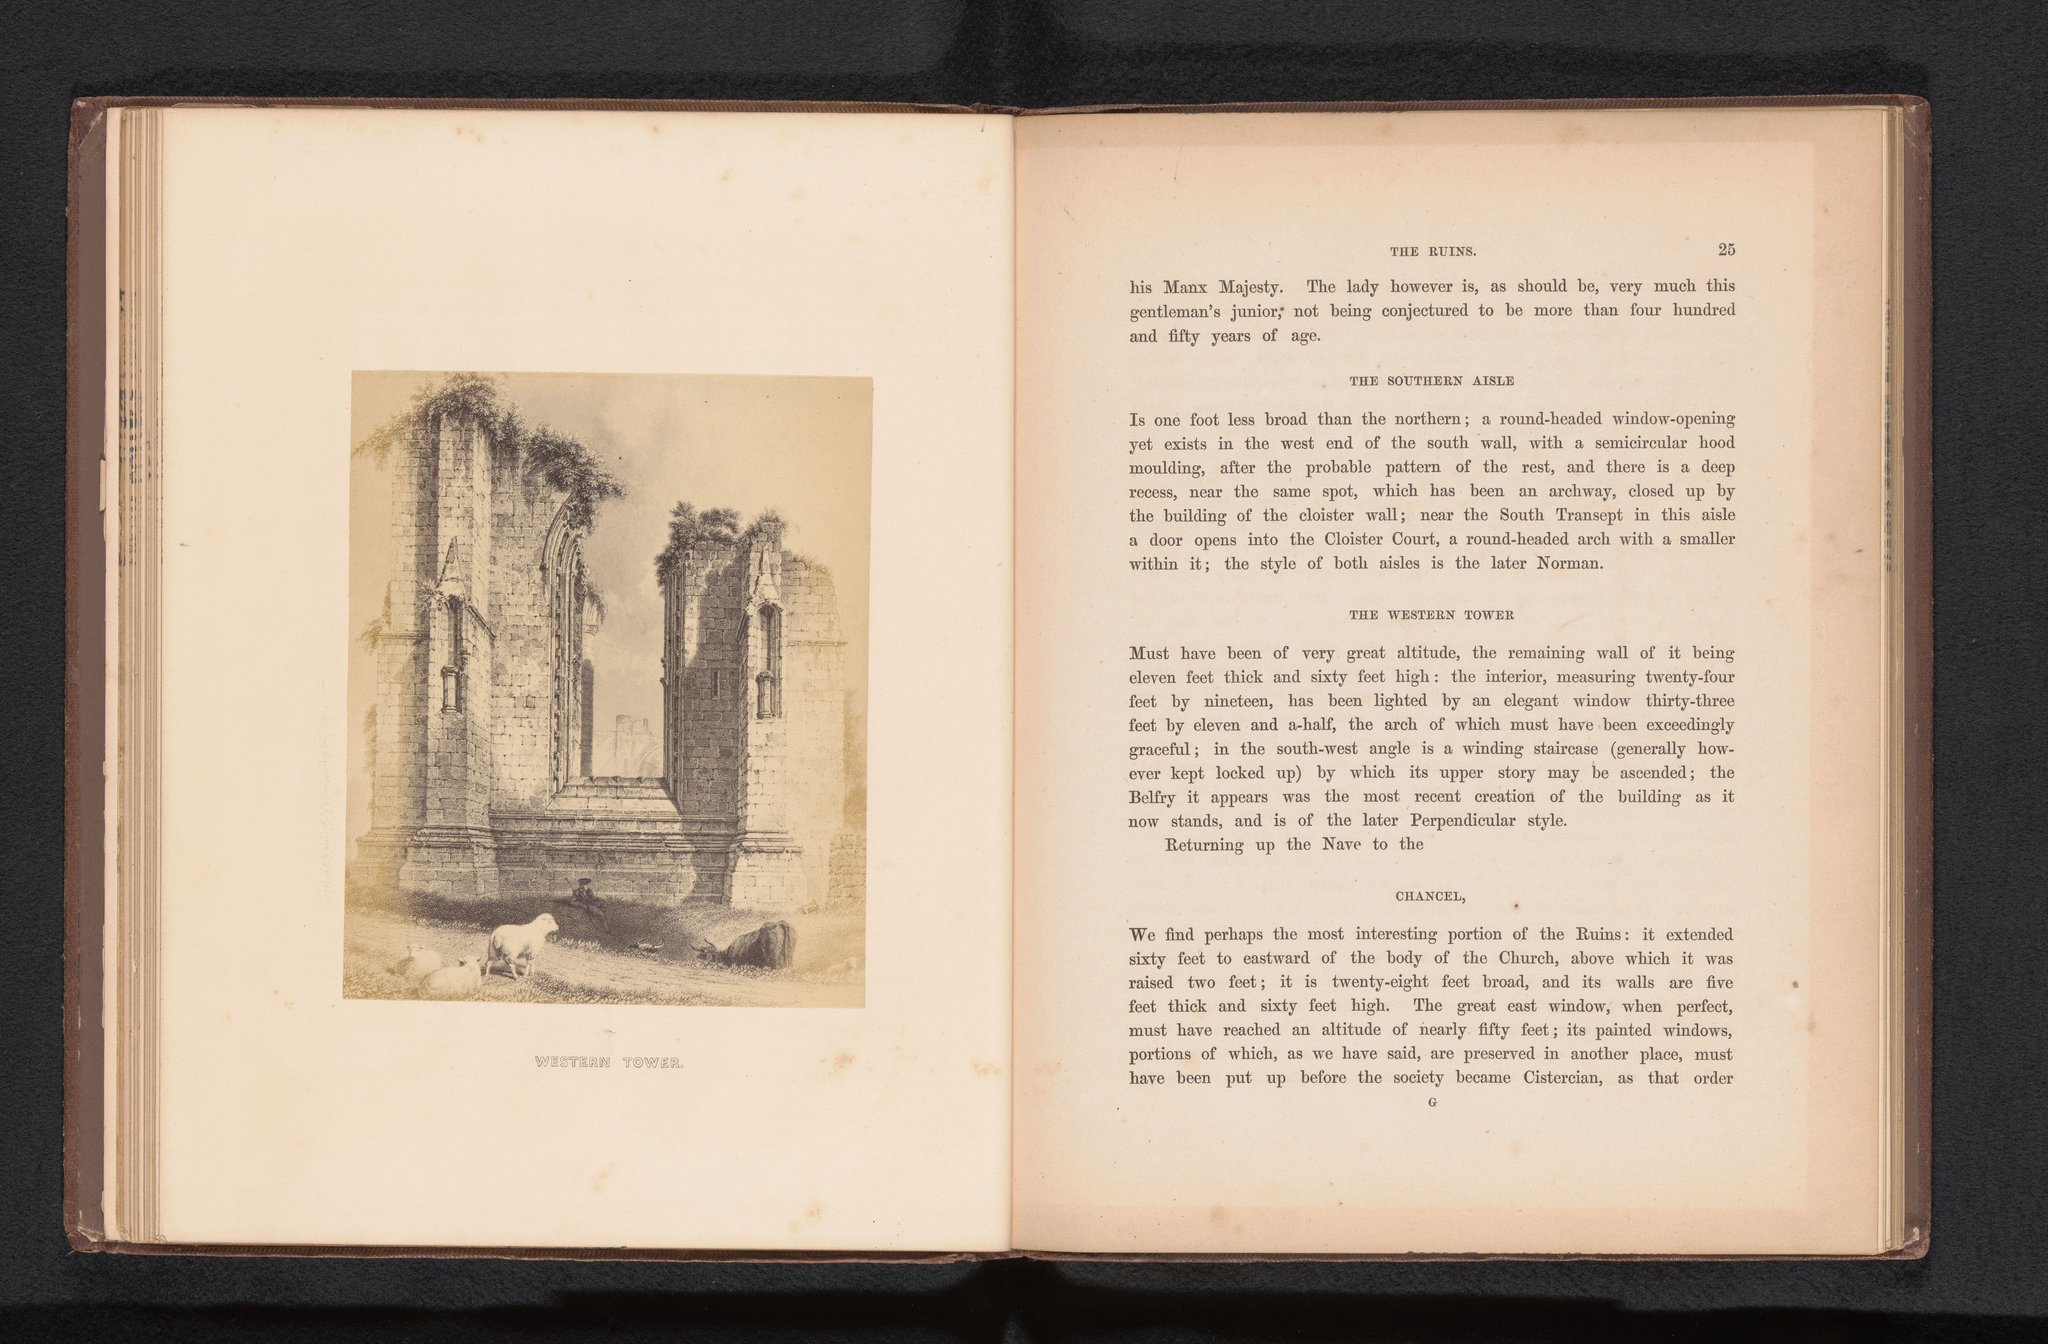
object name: reproduction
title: Western tower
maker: Anonymous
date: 1859-1864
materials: photographic support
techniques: albumen print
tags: ruin of church, monastery, etc.